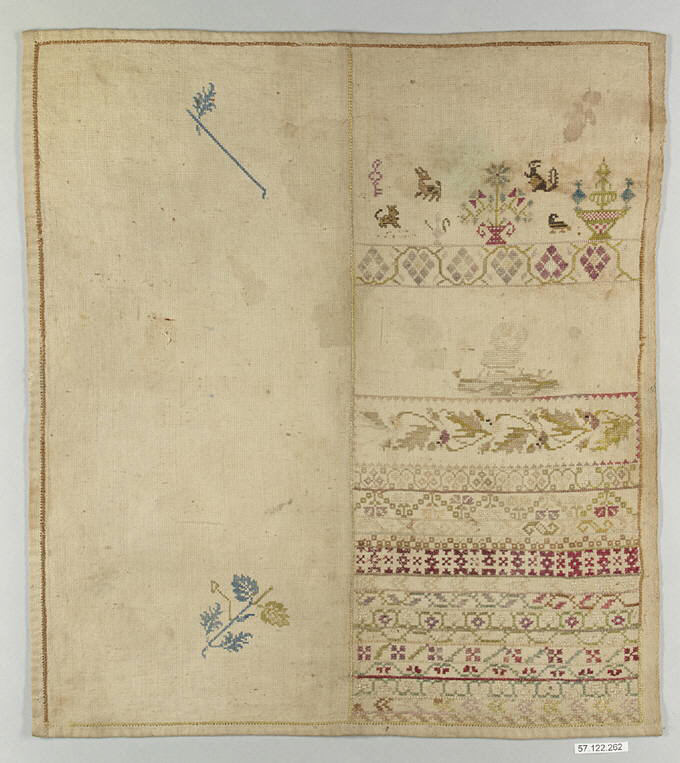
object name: sampler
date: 1801-1900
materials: cotton, silk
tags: flowers